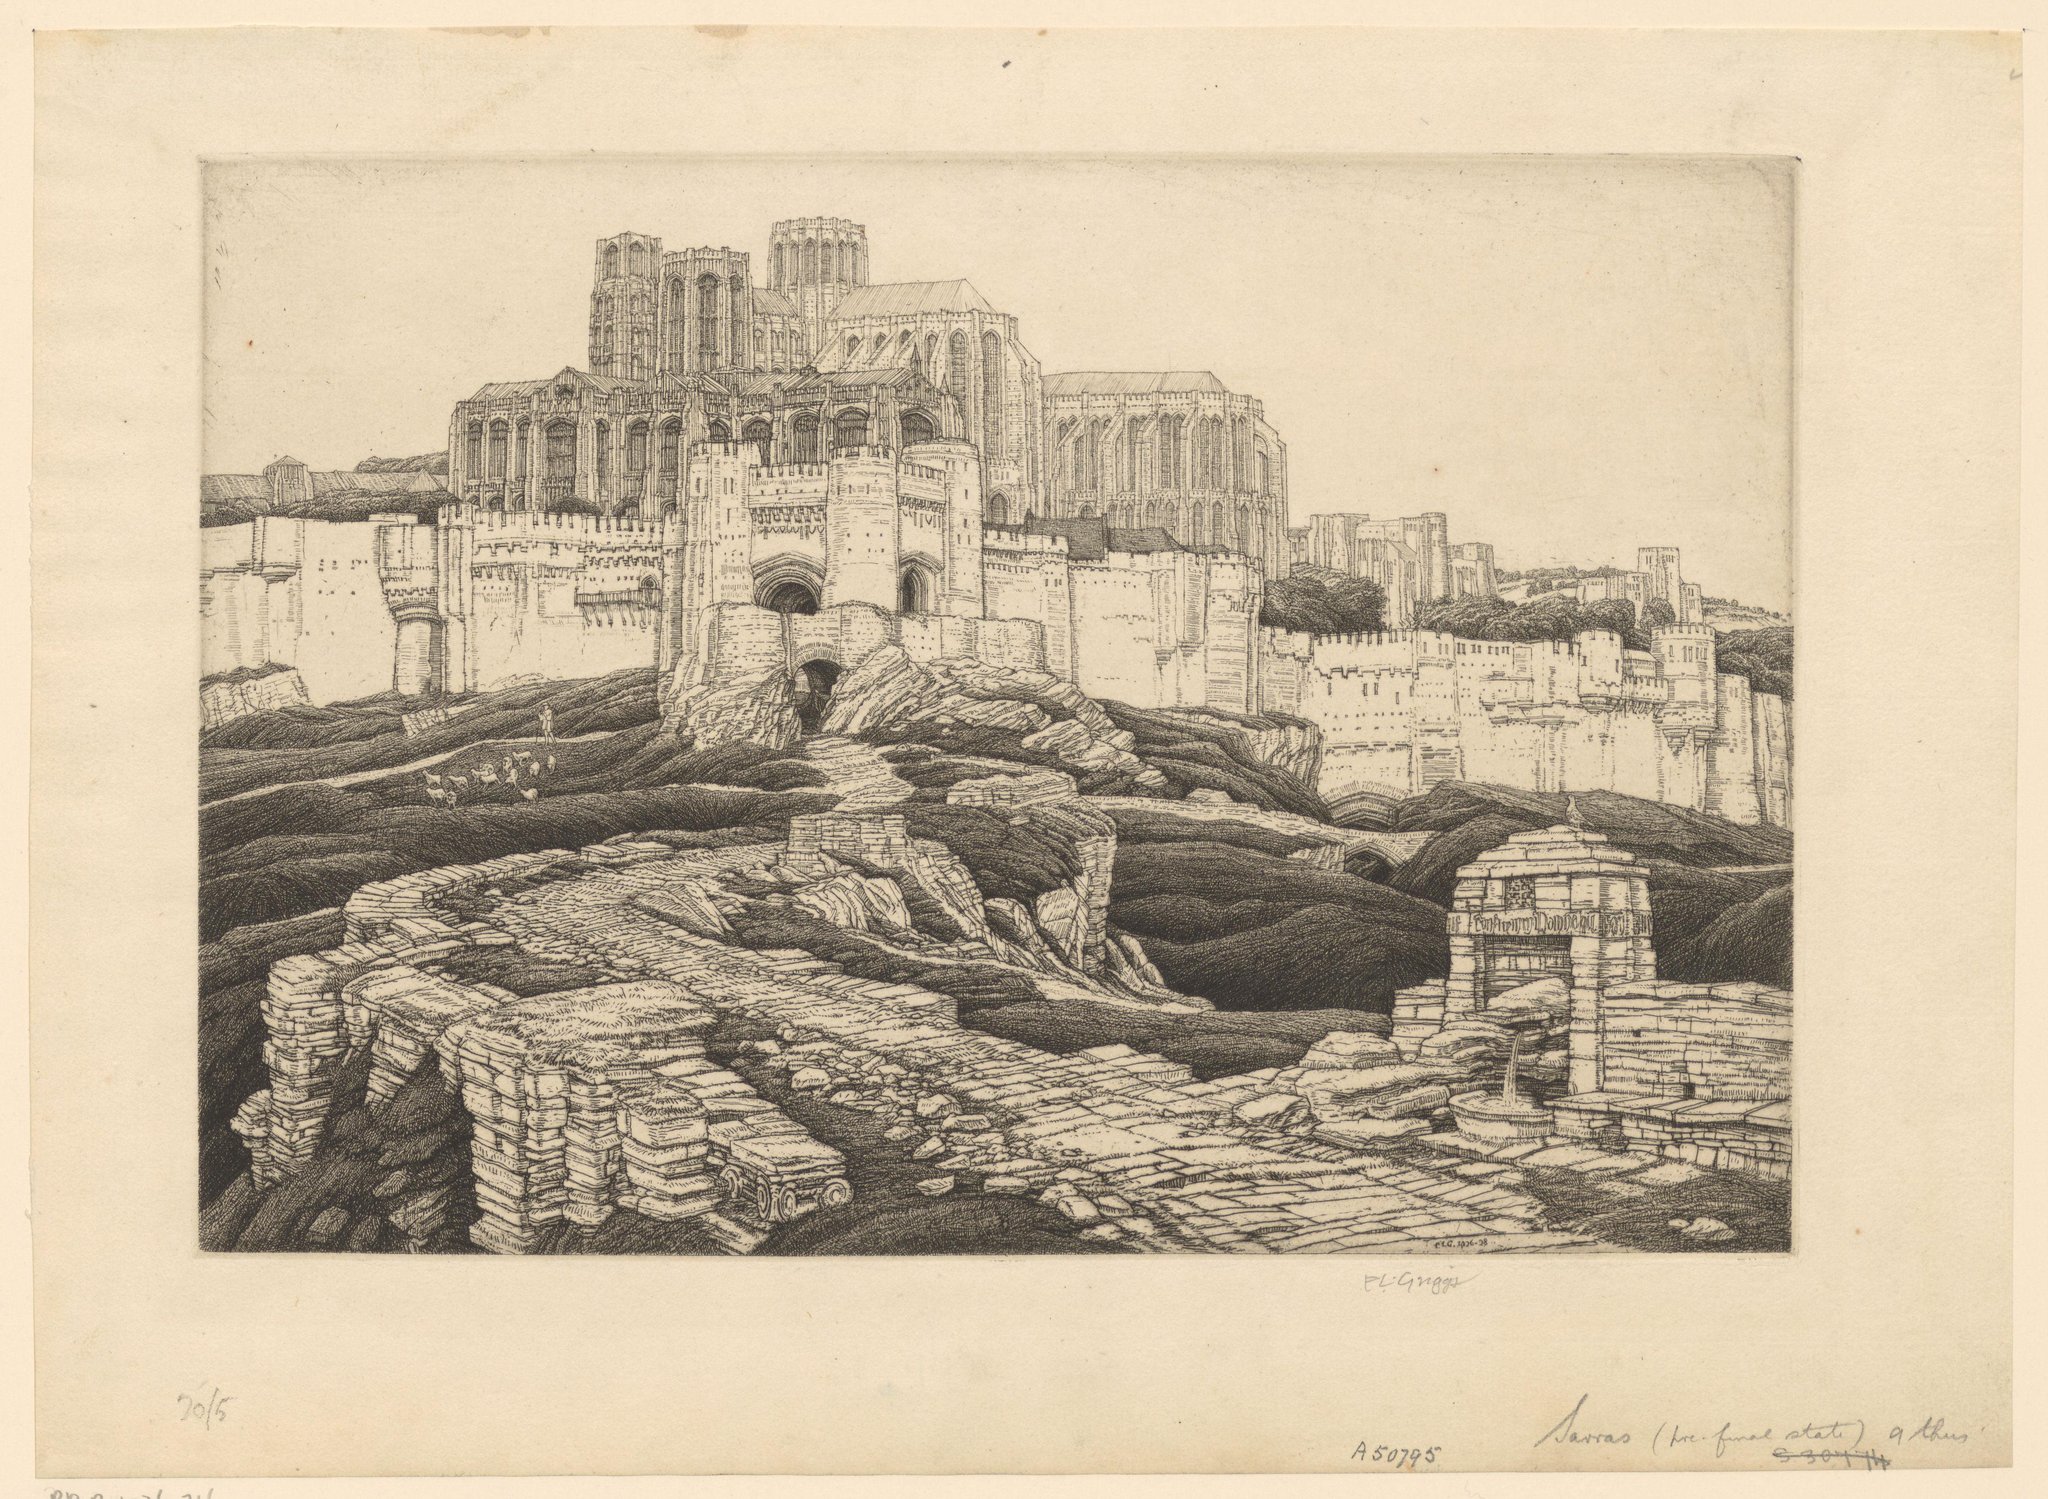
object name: print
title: Stenen pad leidt naar een ommuurde stad met gotische kathedraal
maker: frederick landseer maur griggs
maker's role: print maker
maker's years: 1876-1938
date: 1926-1928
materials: paper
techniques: etching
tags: city-walls - ii - ideal city, city-gate - ii - ideal city, church (exterior), road, path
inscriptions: collector's mark: Lugt 760a, signature: ‘F.L. Griggs’, collector's mark: Lugt 2228